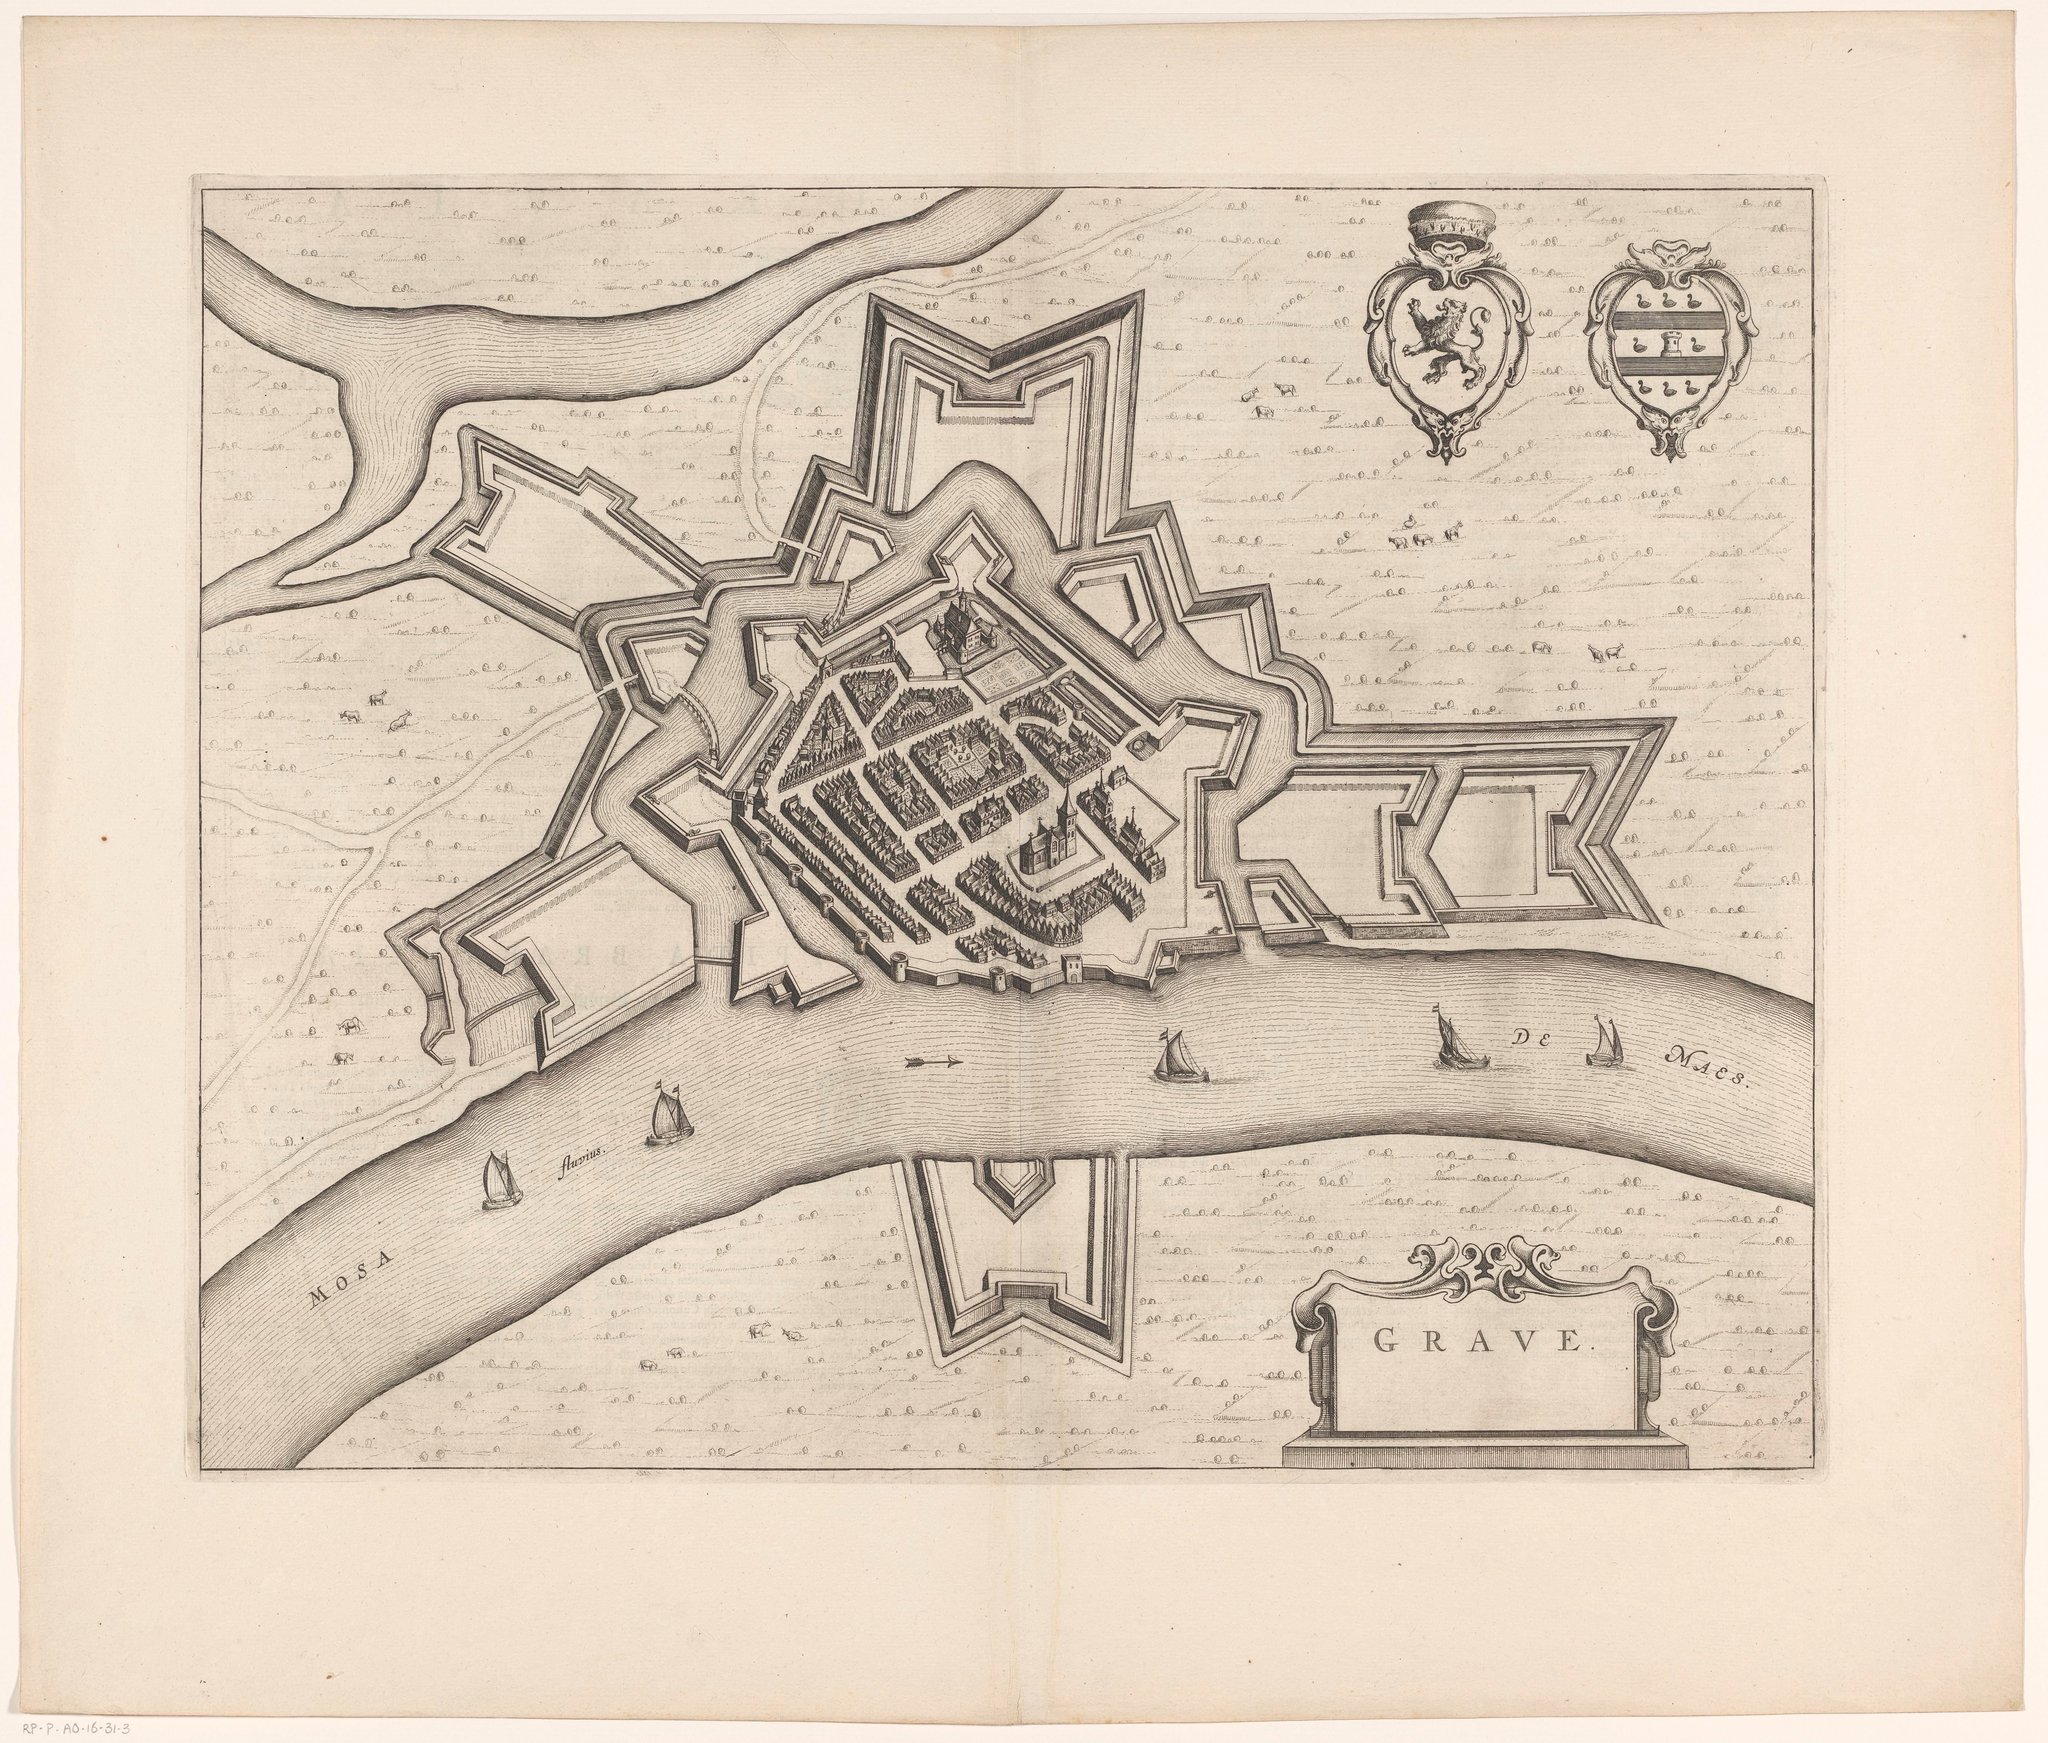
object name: area plan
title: Grave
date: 1652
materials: paper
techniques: engraving, etching, letterpress printing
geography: amsterdam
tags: coat of arms (as symbol of the state, etc.) (+ city; municipal), fortified city, maps of cities, coat of arms (as symbol of the state, etc.) (+ province; provincial), grave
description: Vestingplattegrond van Grave in vogelvluchtperspectief. Rechtsonder de titelcartouche. Rechtsboven twee wapenschilden. Links het wapen van Brabant, rechts het wapen van Grave. Op verso Latijnse tekst.